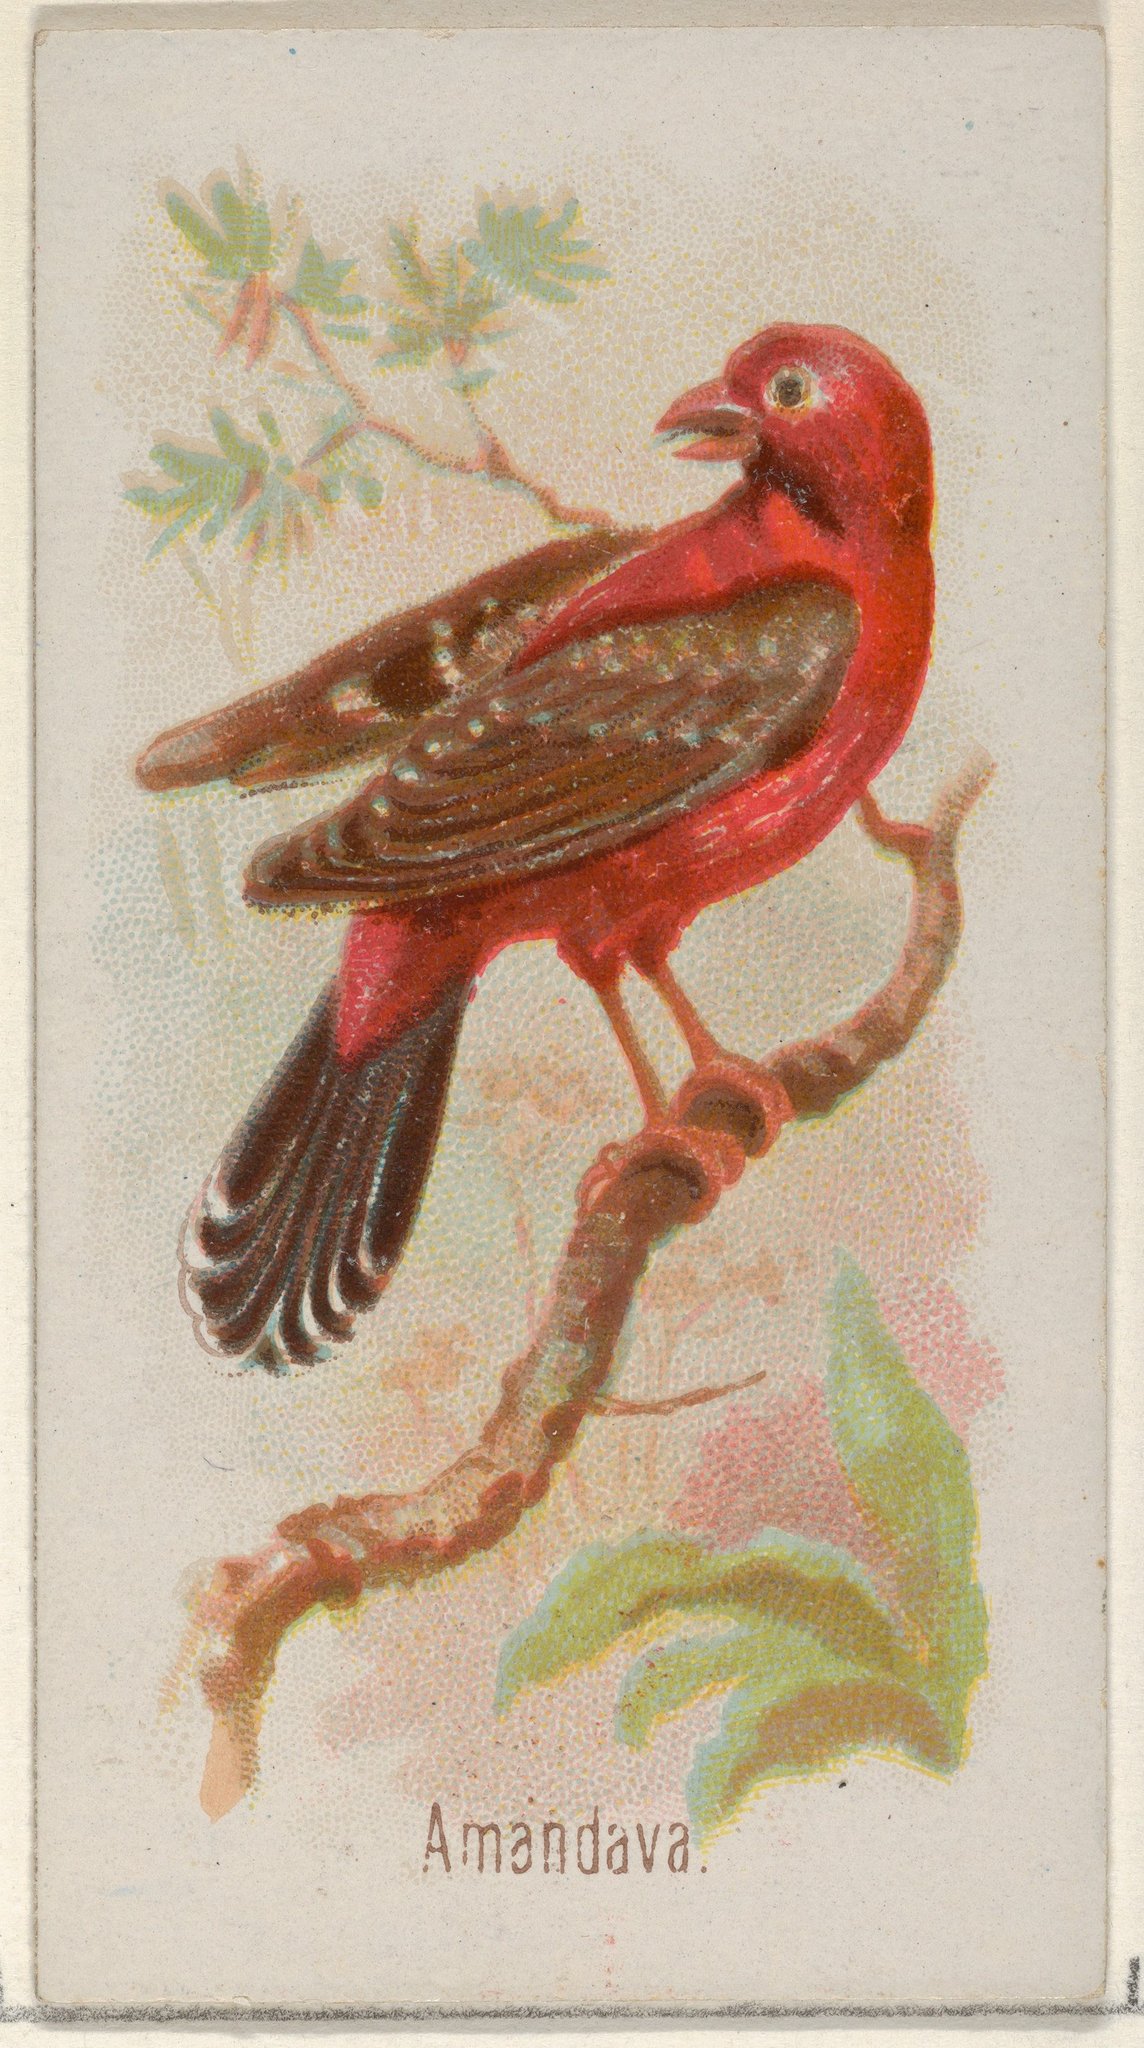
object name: print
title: Amandava, from the Song Birds of the World series (N23) for Allen & Ginter Cigarettes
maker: allen & ginter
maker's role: publisher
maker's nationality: american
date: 1890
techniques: color lithograph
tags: birds